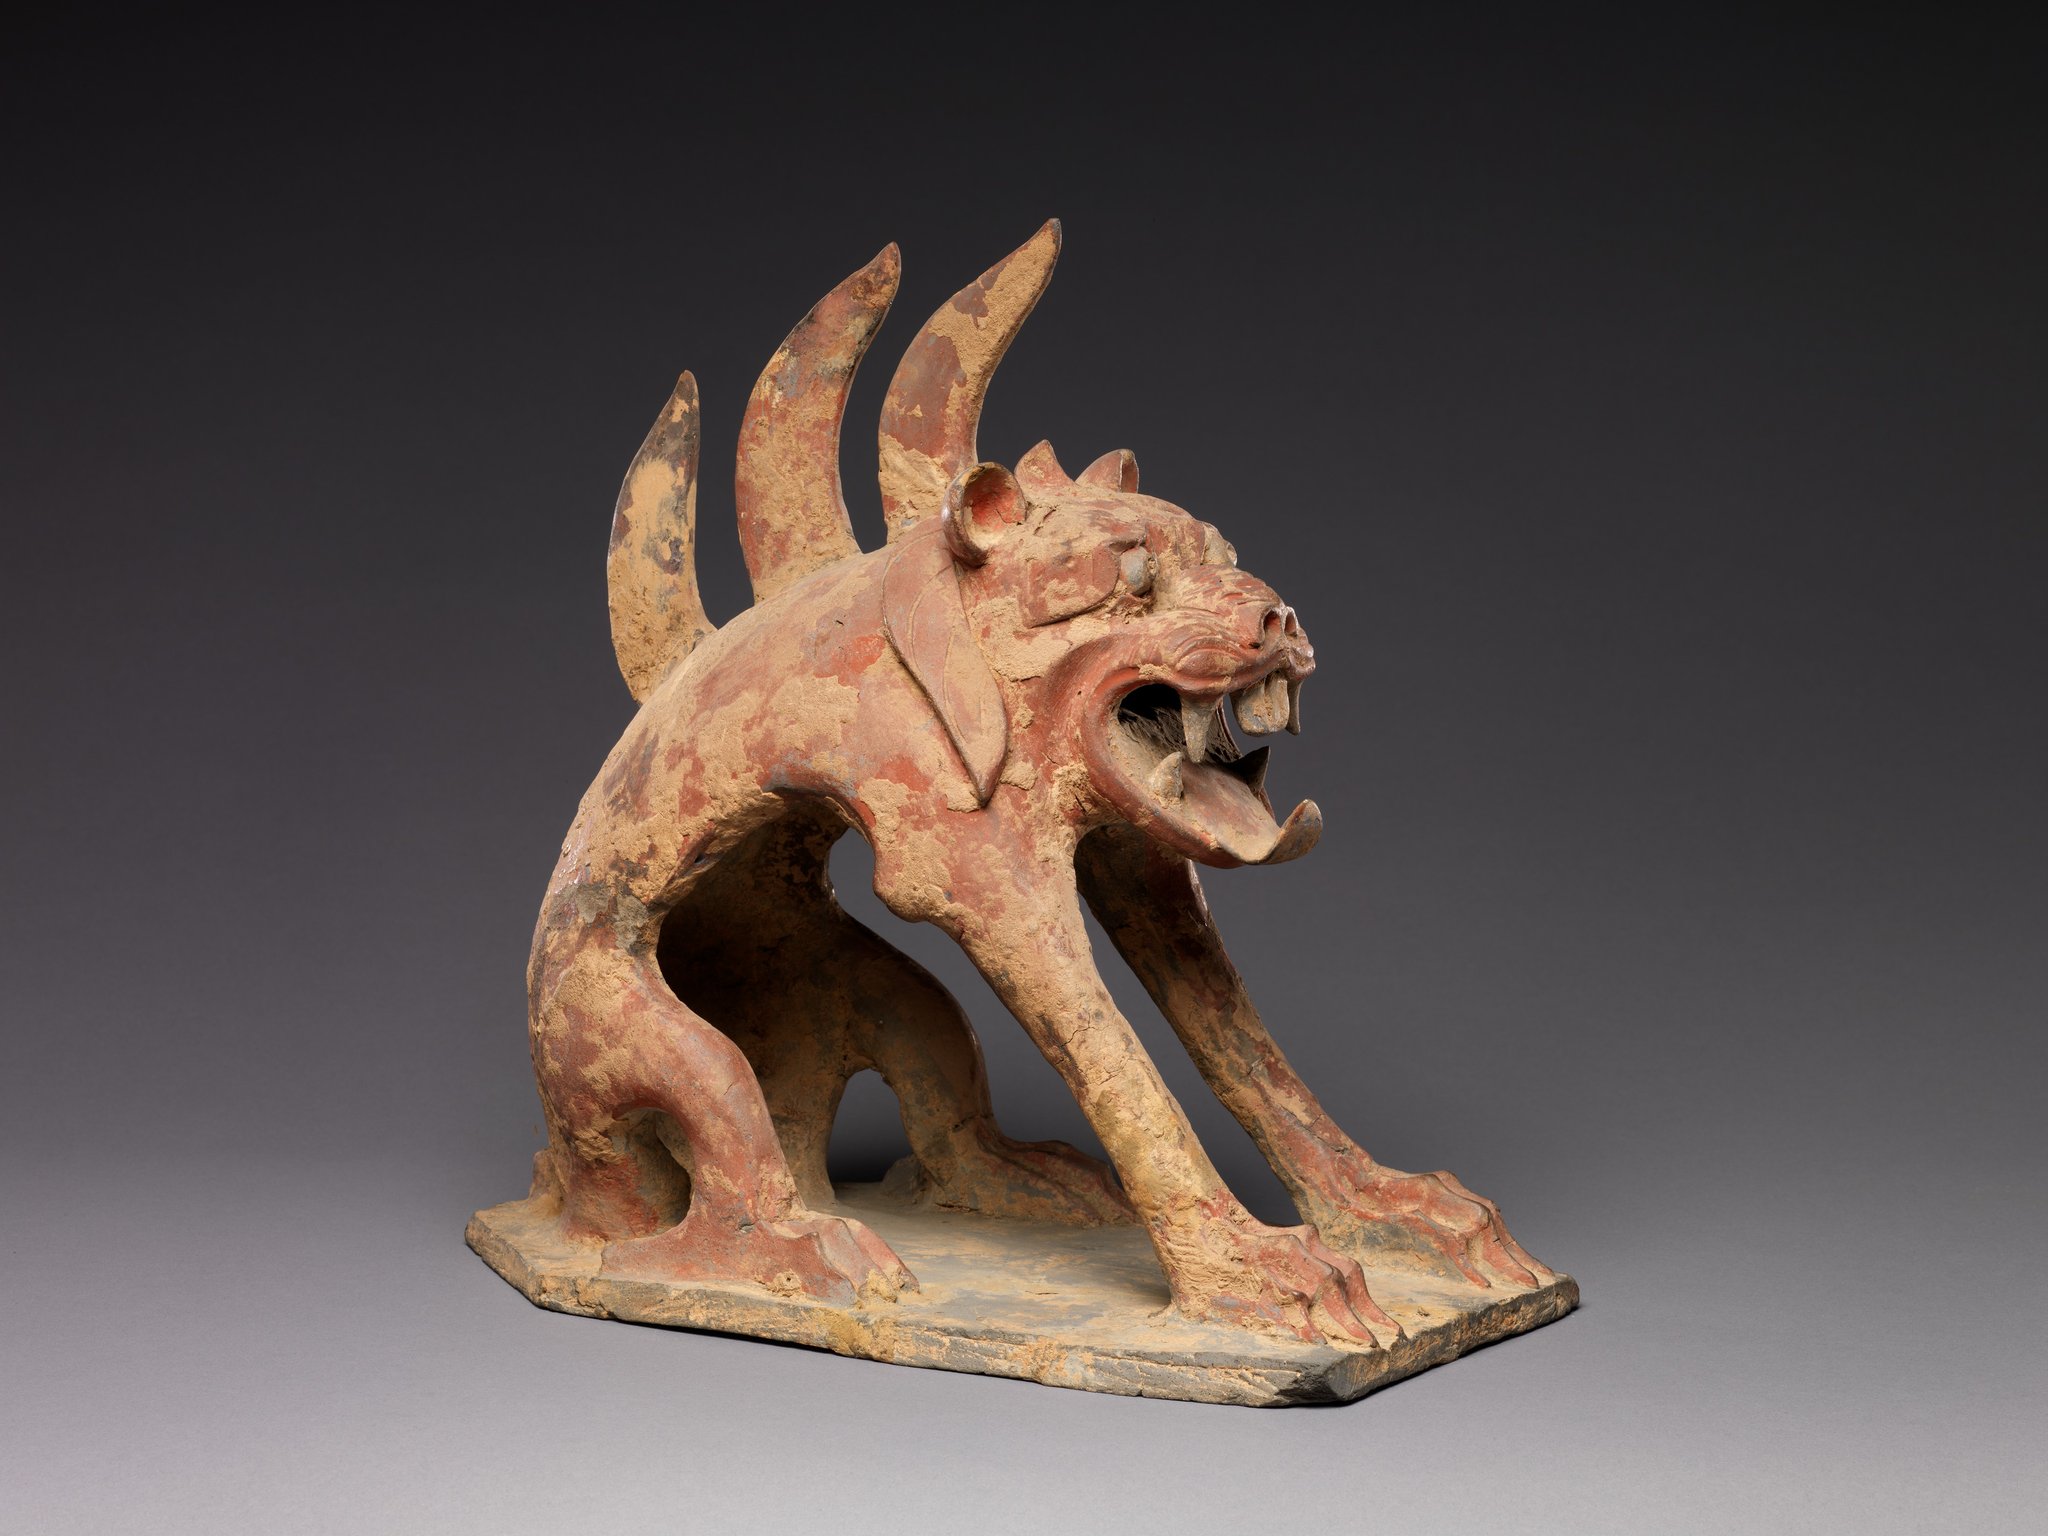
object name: figure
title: Tomb Guardian (Zhenmushou)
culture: chinese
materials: earthenware, pigment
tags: mythical creatures